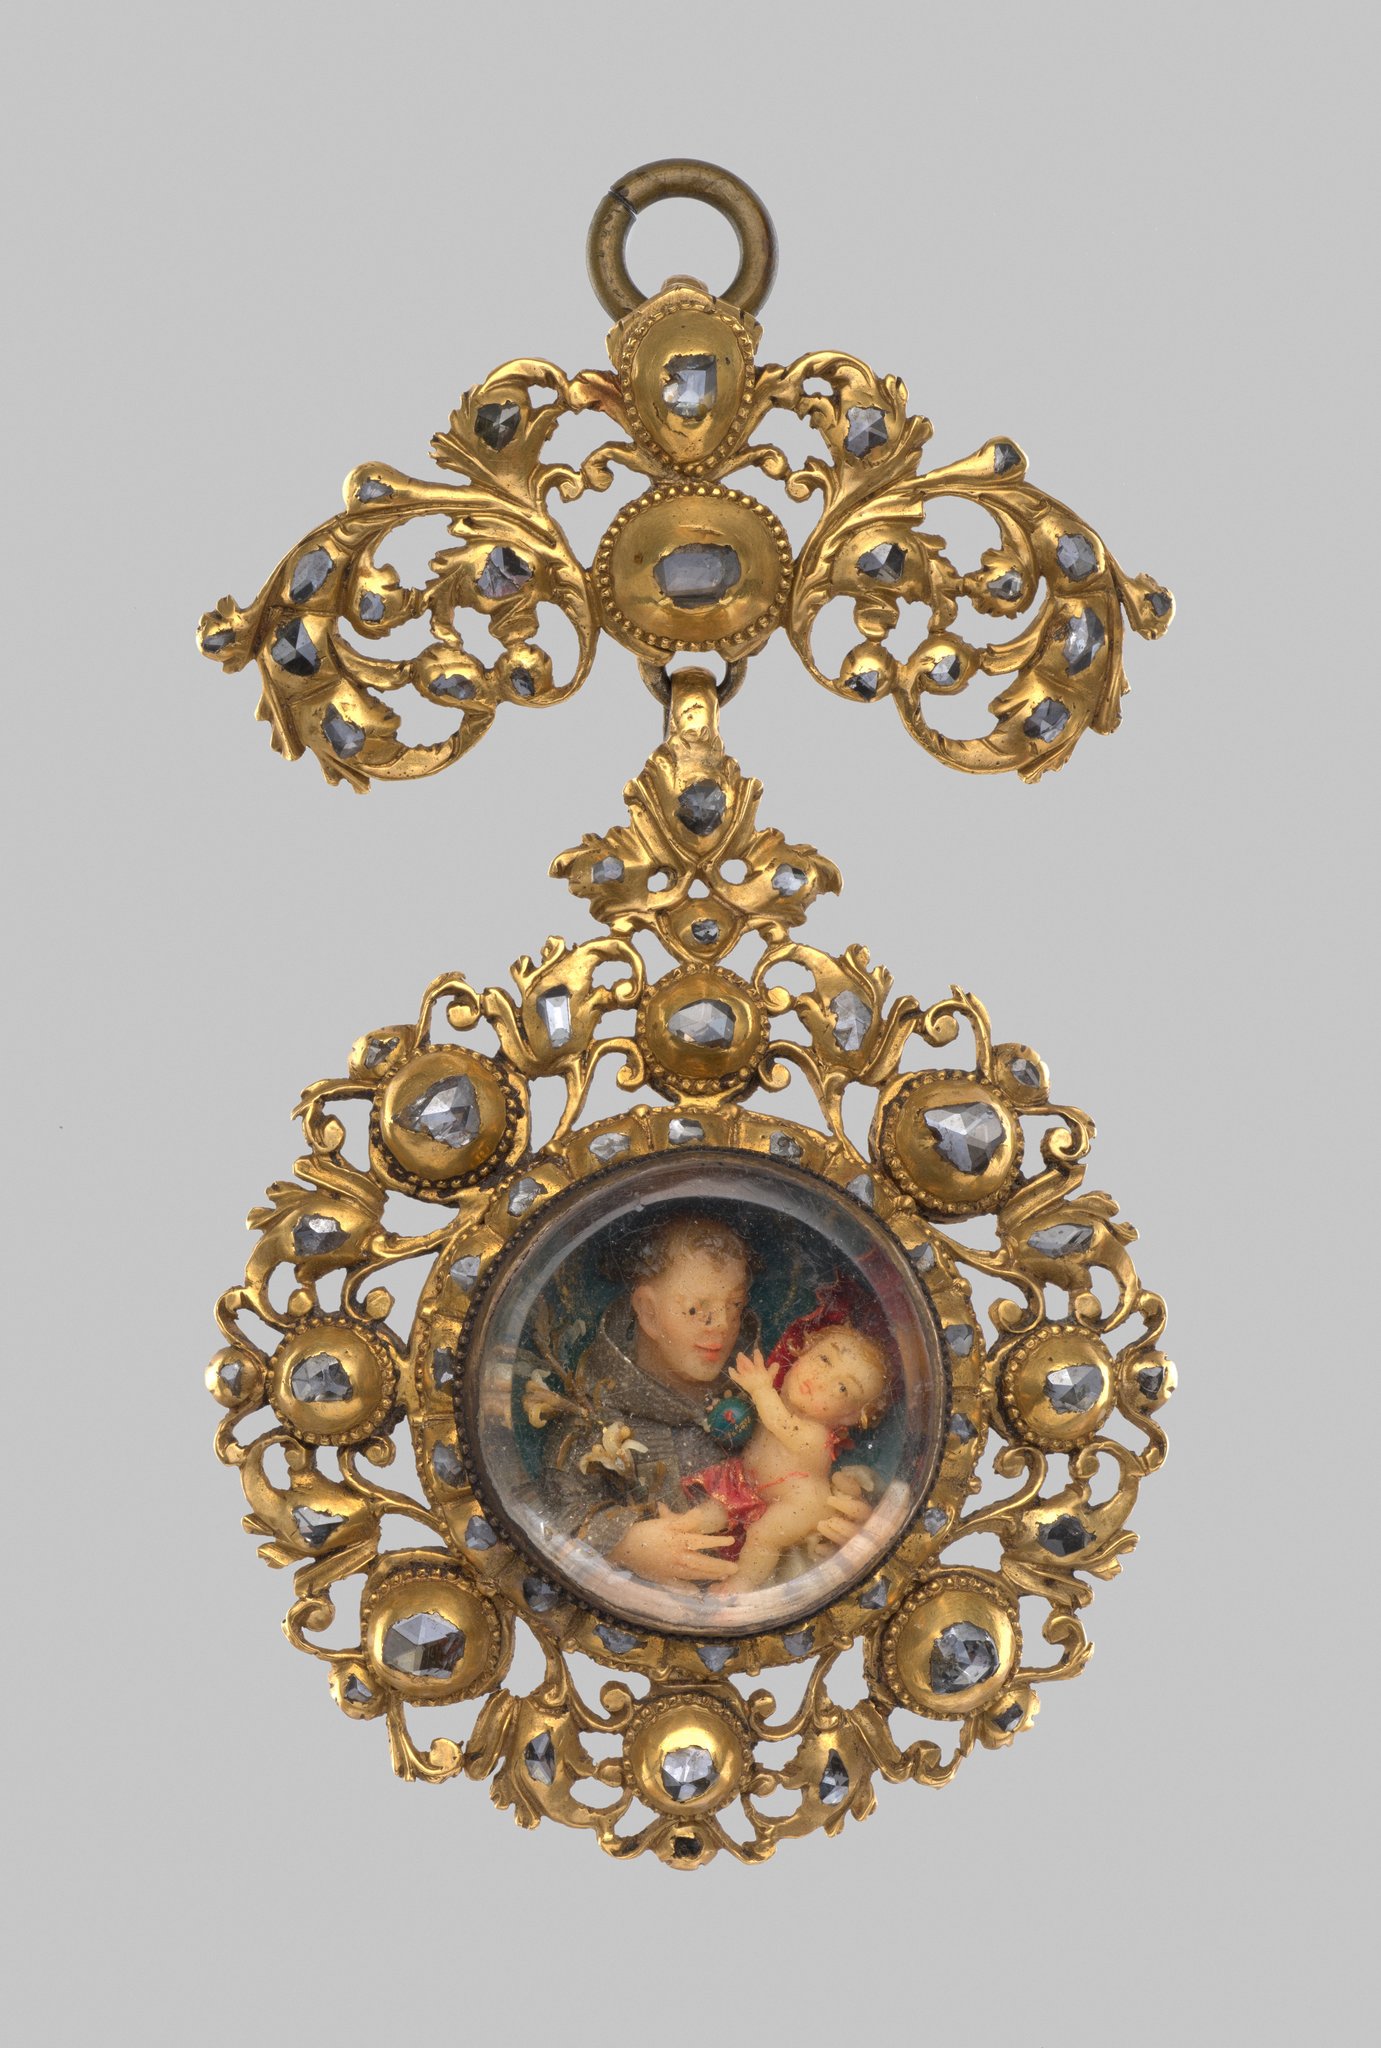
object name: pendant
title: Pendant with relief of St. Anthony of Padua with Christ Child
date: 1667-1700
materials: diamond, gold, wax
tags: men,jesus